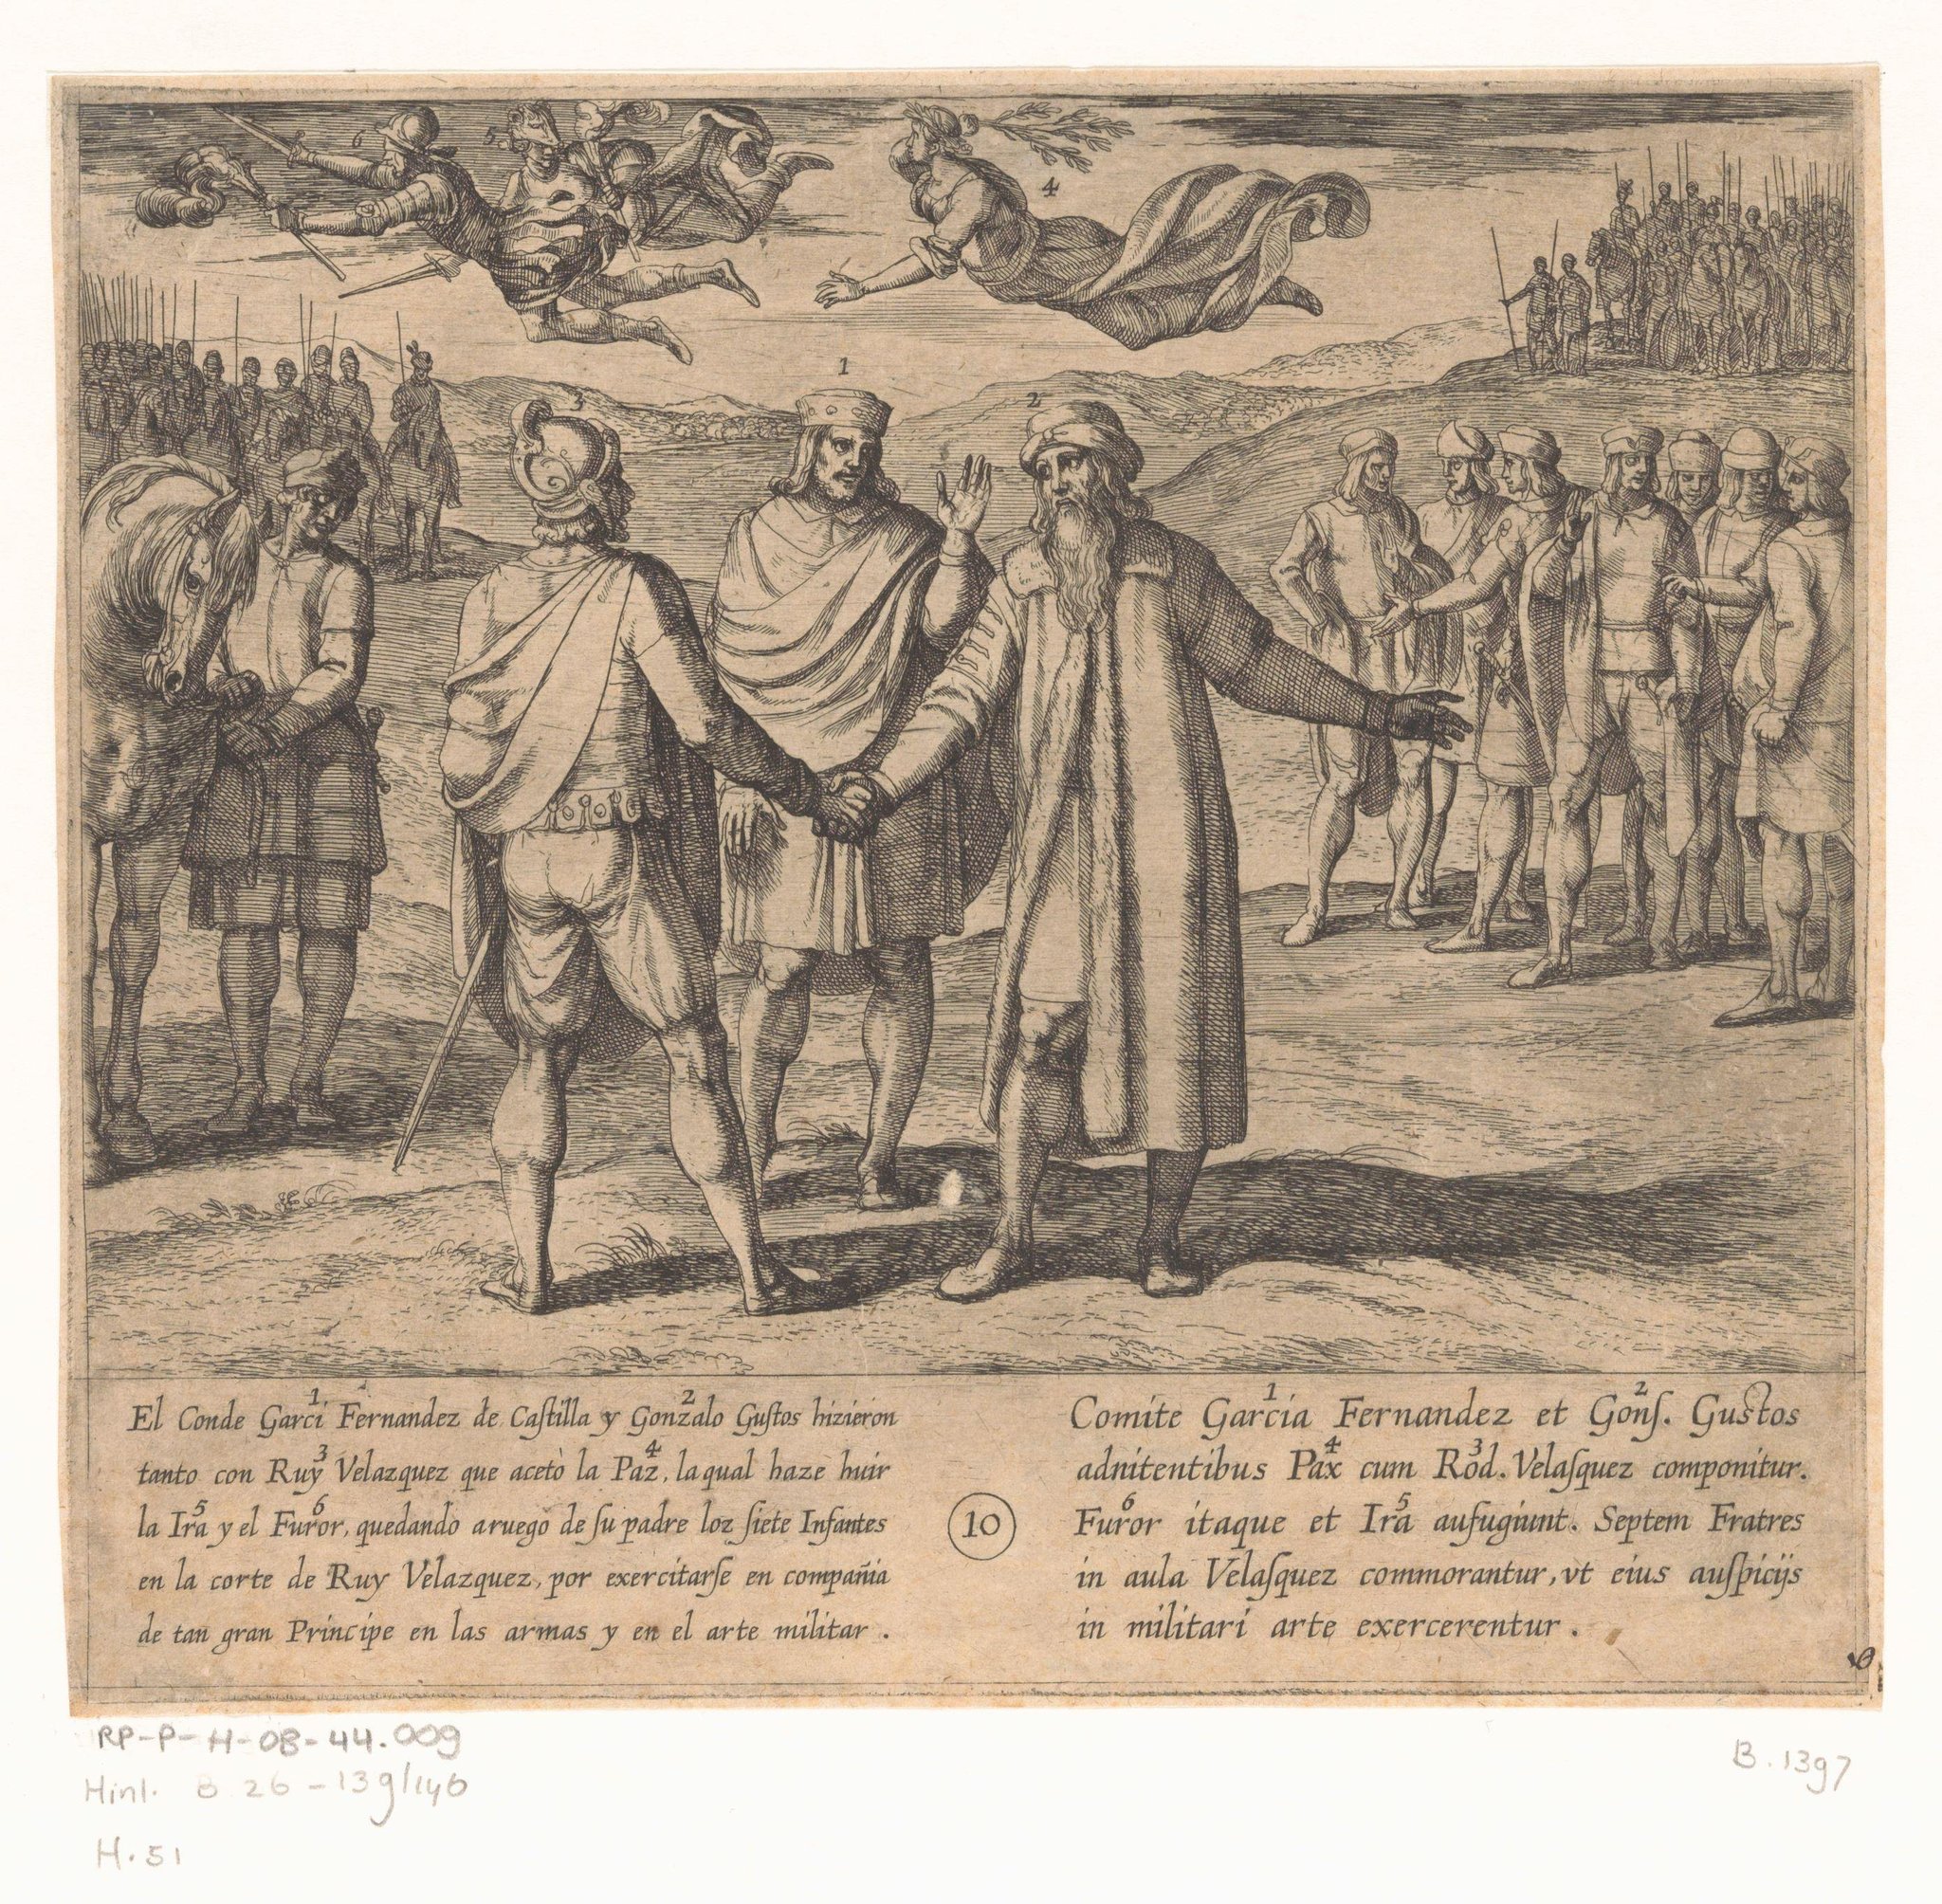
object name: print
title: De zeven infanten van Lara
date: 1612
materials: paper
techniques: etching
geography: italy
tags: peace negotiations, tales and fairy tales, peace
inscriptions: number: ‘10’, collector's mark: Lugt 11, collector's mark: ‘Hinloopen’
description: Deze prent maakt deel uit van een reeks van 40 prenten (+ titelprent) met voorstellingen uit het volksverhaal over de zeven infanten van Lara.